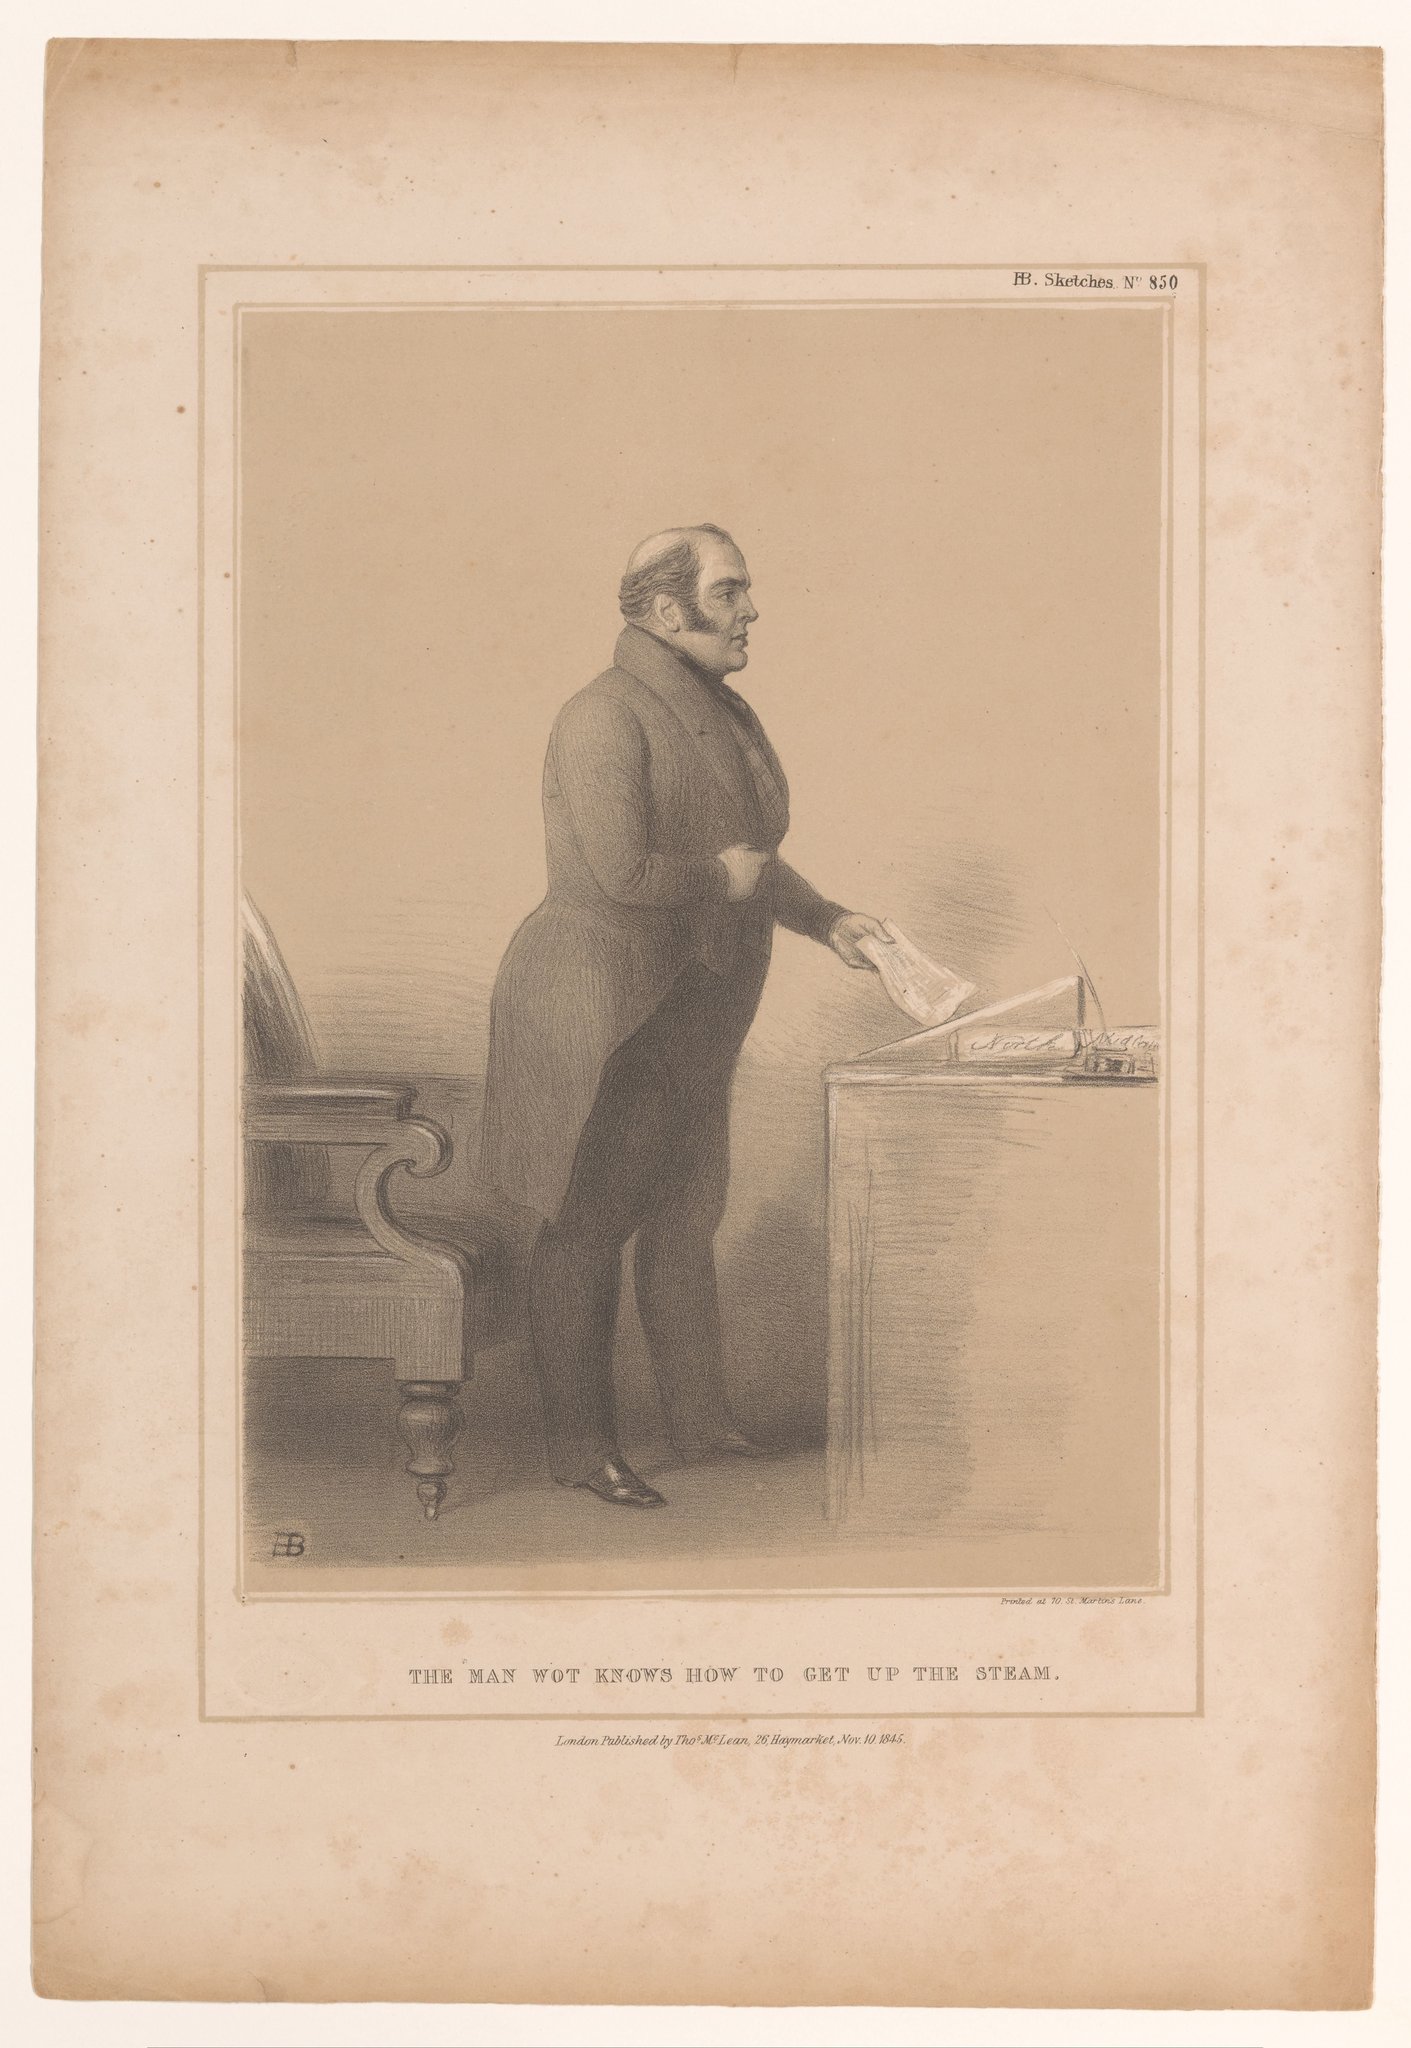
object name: print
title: The man wot knows how to get up the steam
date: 1845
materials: paper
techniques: tone lithography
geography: london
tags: political caricatures and satires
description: Portret van George Hudson, staande bij een spreekgestoelte. Uitgegeven als nr. 850 in de serie HB Sketches.